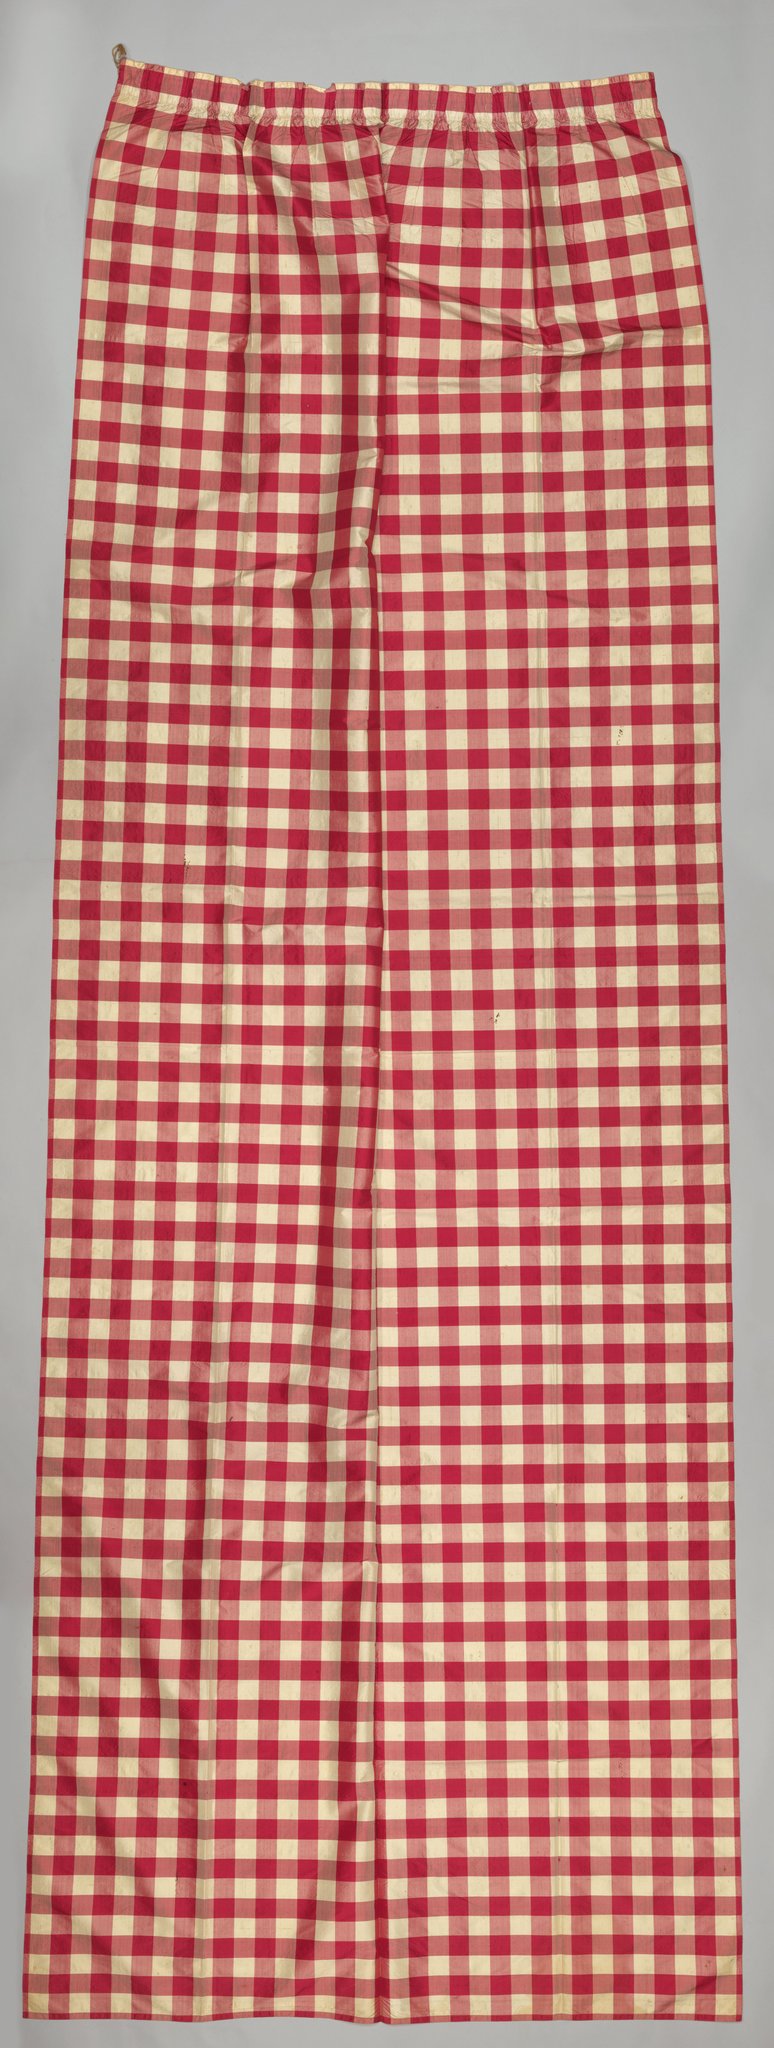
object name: silk textile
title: Rood-wit geblokt gordijn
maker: Anonymous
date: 1776-1800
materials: linen, silk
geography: northern netherlands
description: Gordijn van rood-wit geblokte zijde met een gefronst hoofdje. Aan de achterzijde bovenaan een grof linnen rand met koperen ringen. Aan een gordijnring aan het uiteinde is een touwtje bevestigd.